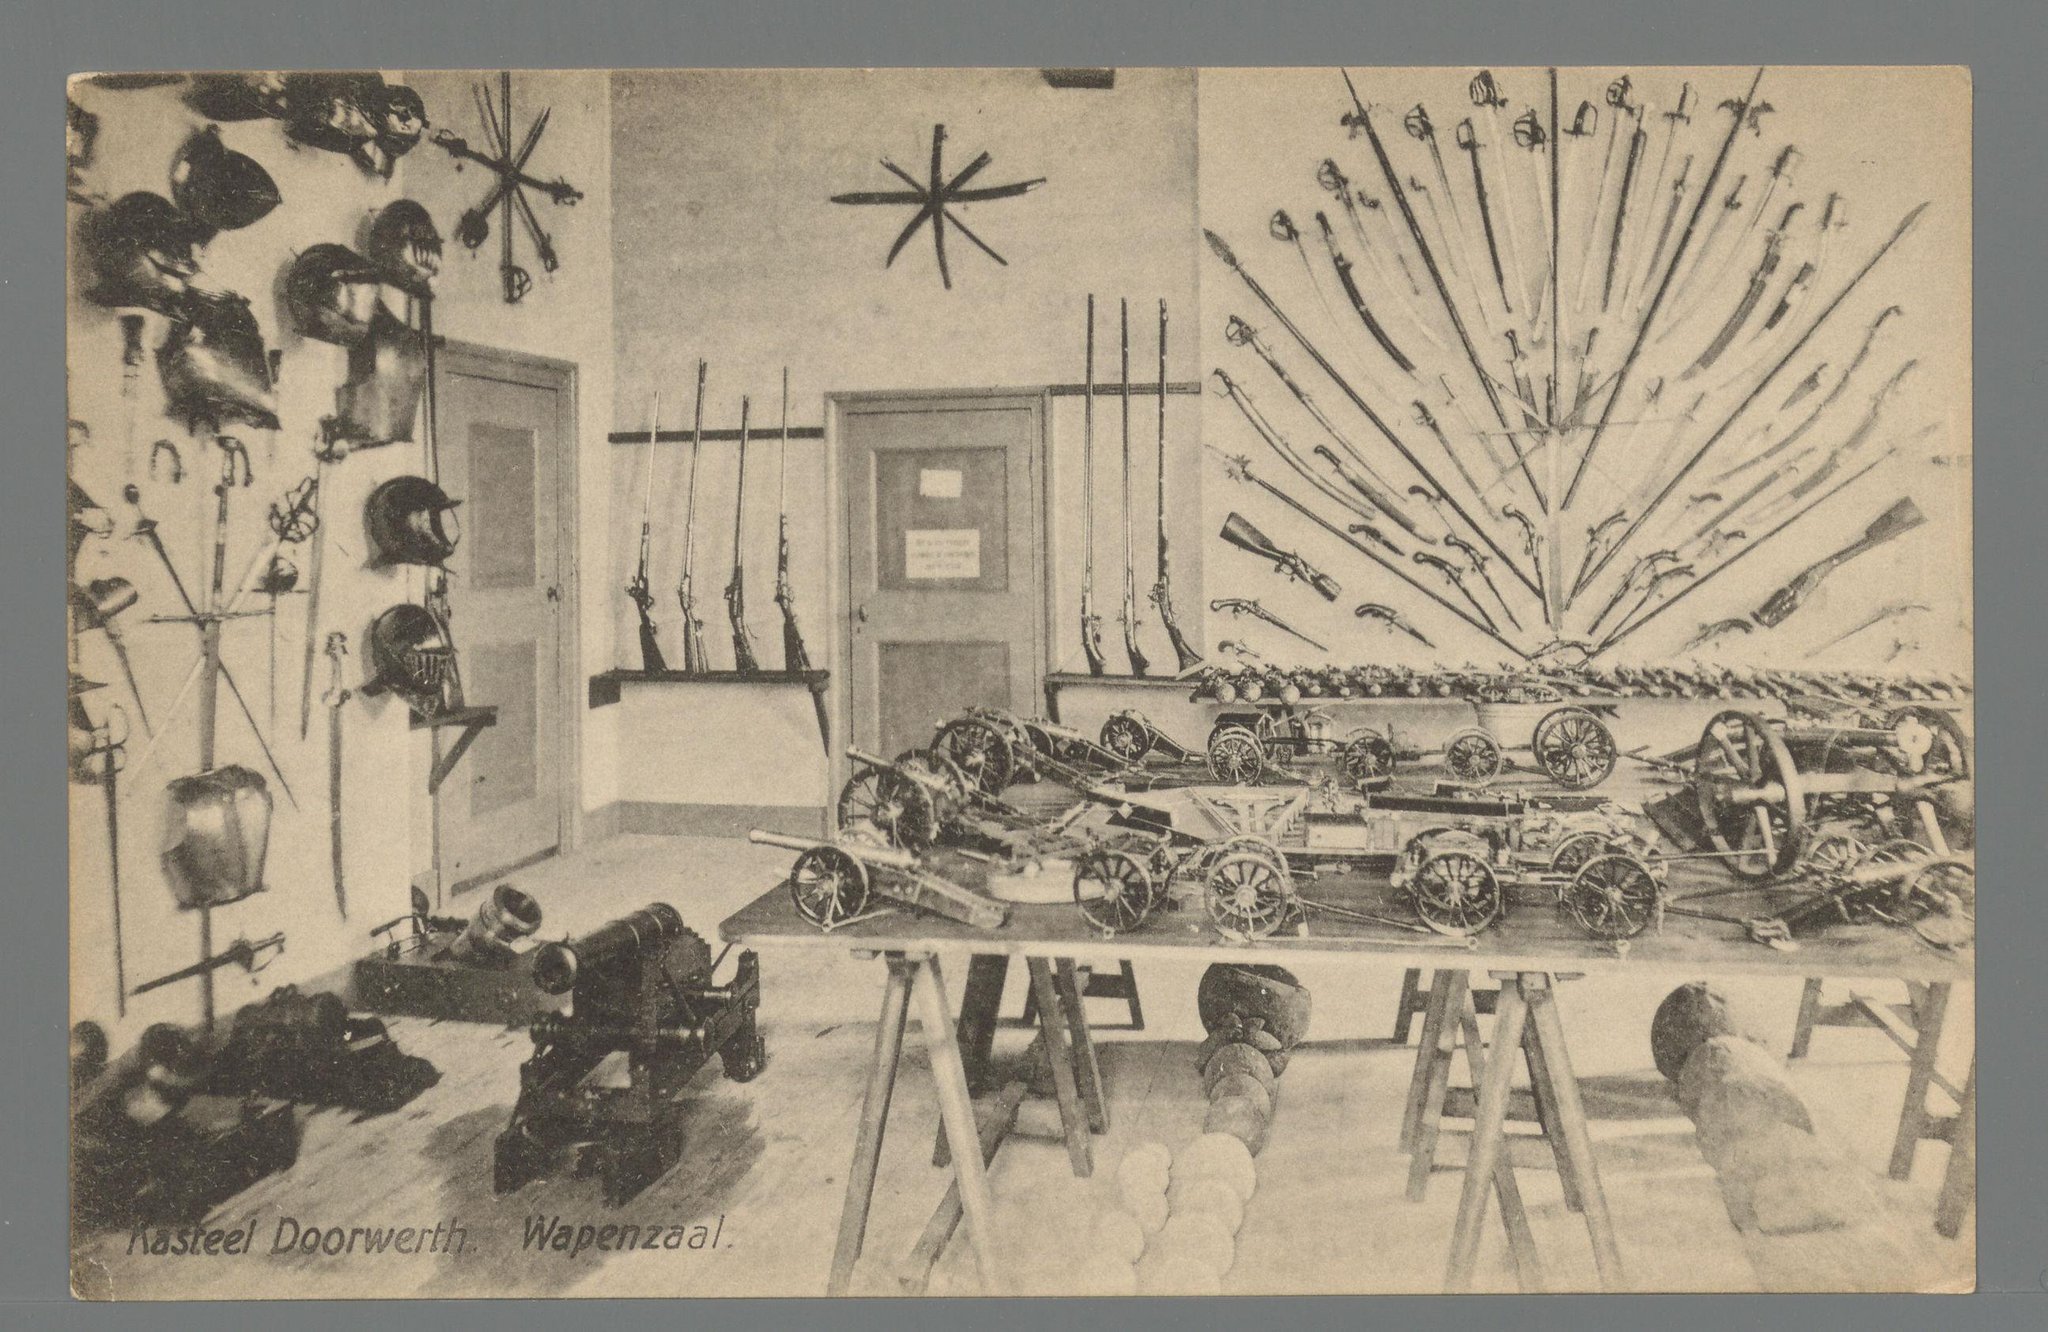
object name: ansichtkaart, prentbriefkaart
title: Kasteel Doorwerth. Wapenzaal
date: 1916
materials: cardboard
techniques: photograph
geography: doorwerth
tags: castle, weapons, interior of the house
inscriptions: date